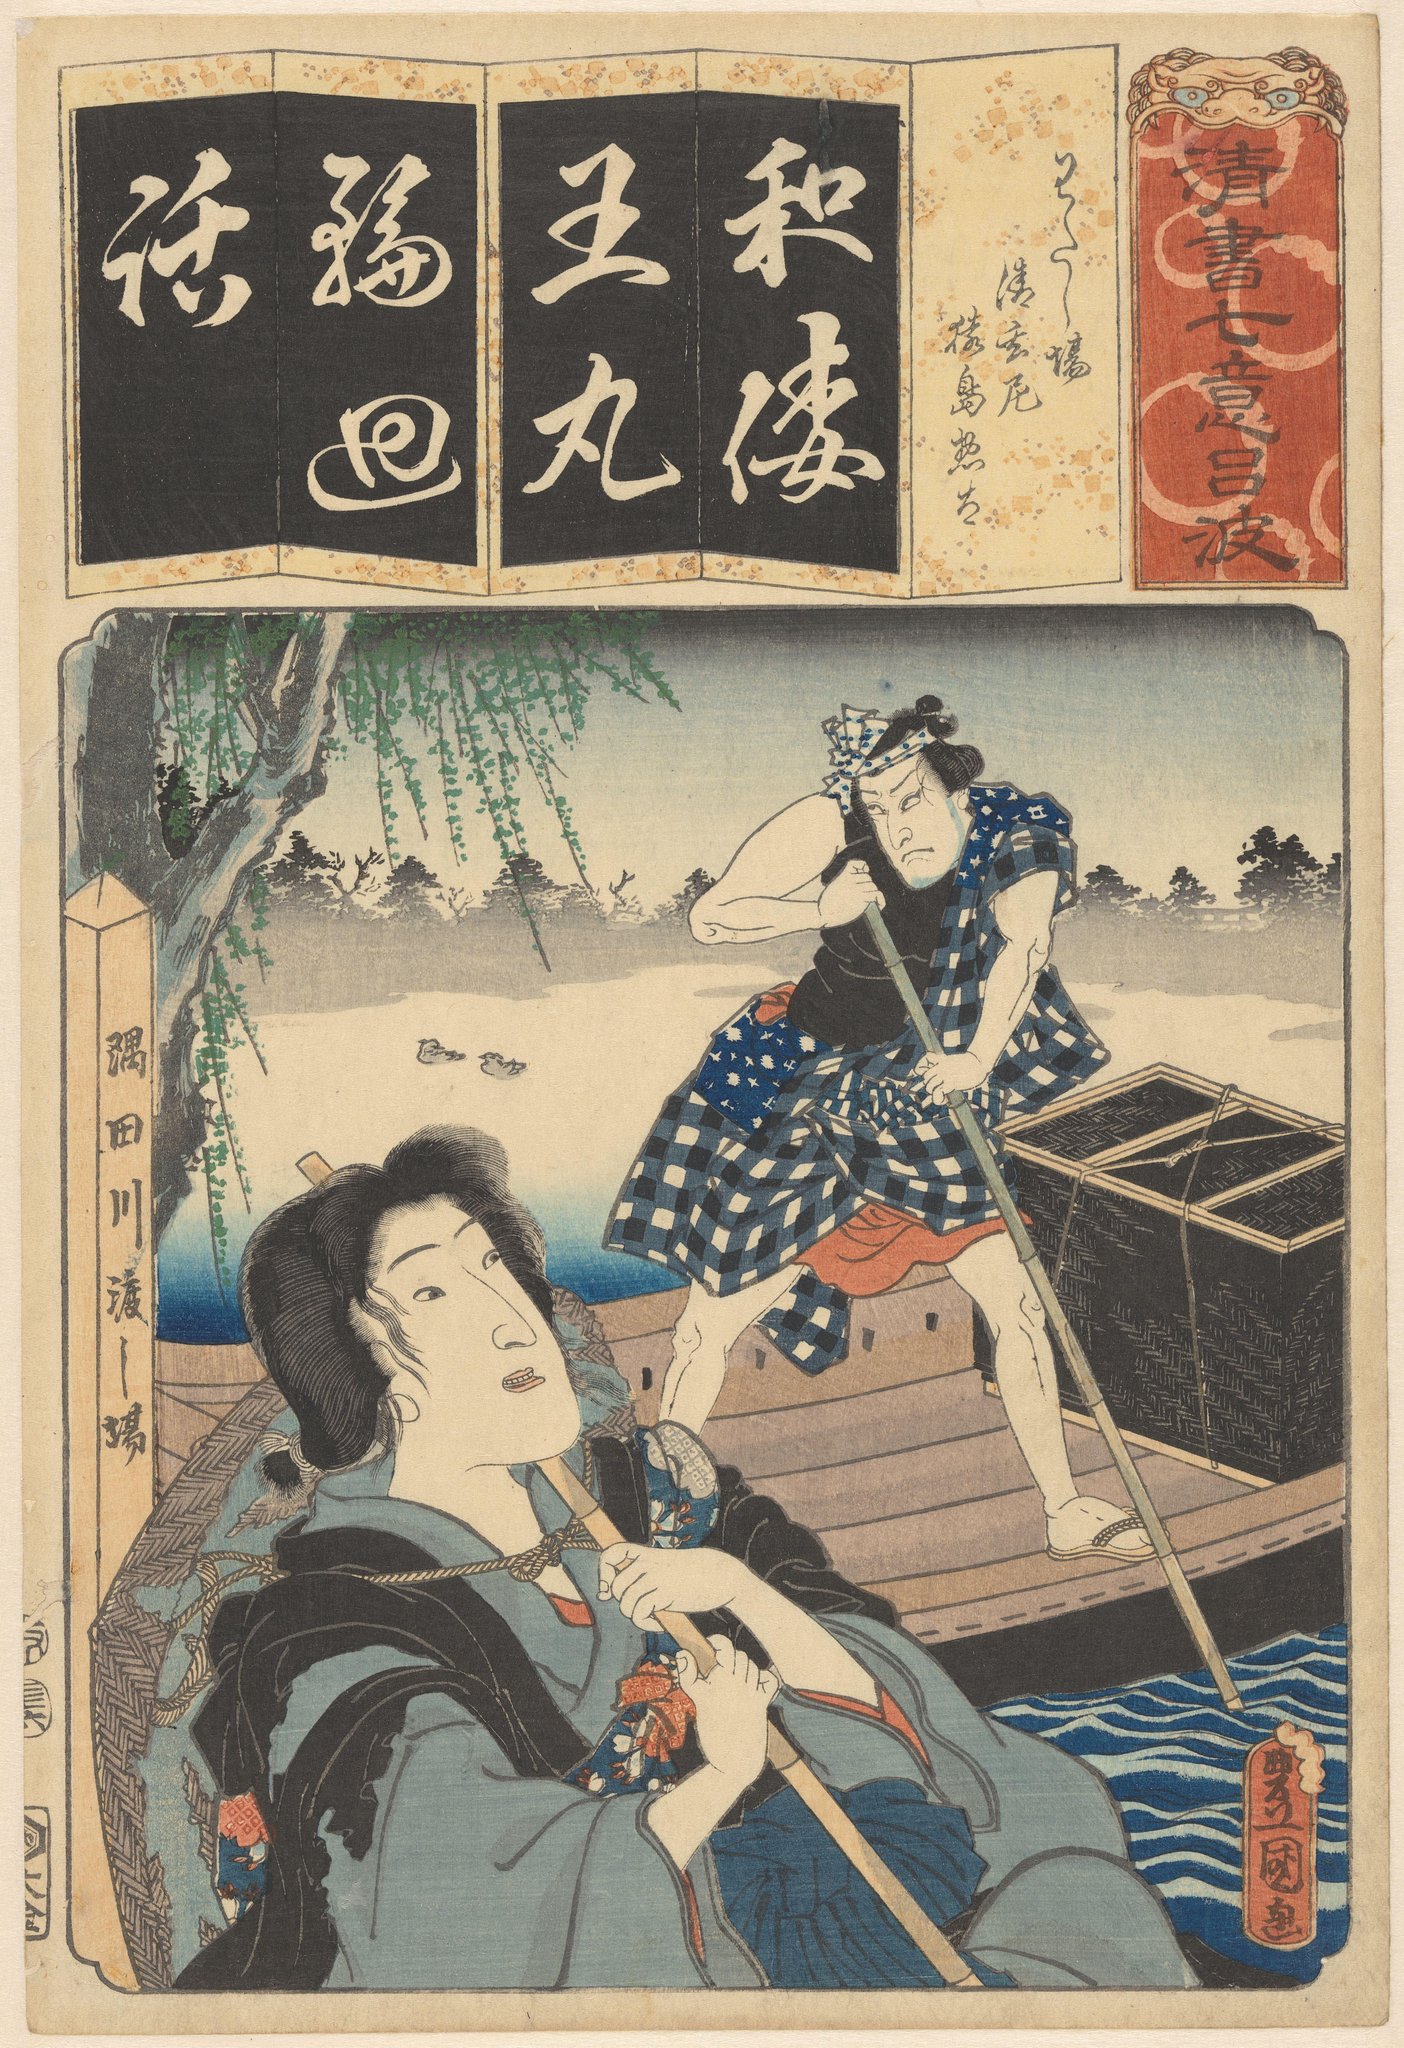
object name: print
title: Seven calligraphic models for each character in the kana syllabary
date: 1856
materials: paper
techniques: woodcut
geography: japan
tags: river, group of actors, troupe; actors on the stage, rowing-boat, canoe, etc.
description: De non Seigen in versleten kleding, en op de achtergrond een veerman die een zwarte kledingkist op zijn veerboot over de rivier de Sumida vervoert. Scene uit een kabuki toneelstuk. De rol van de Seigen wordt gespeeld door acteur Iwai Kumesaburô III en de rol van de veerman door Ichikawa Kôdanji IV. Opgevoerd in het Ichimura theater vanaf de derde maand van 1853.